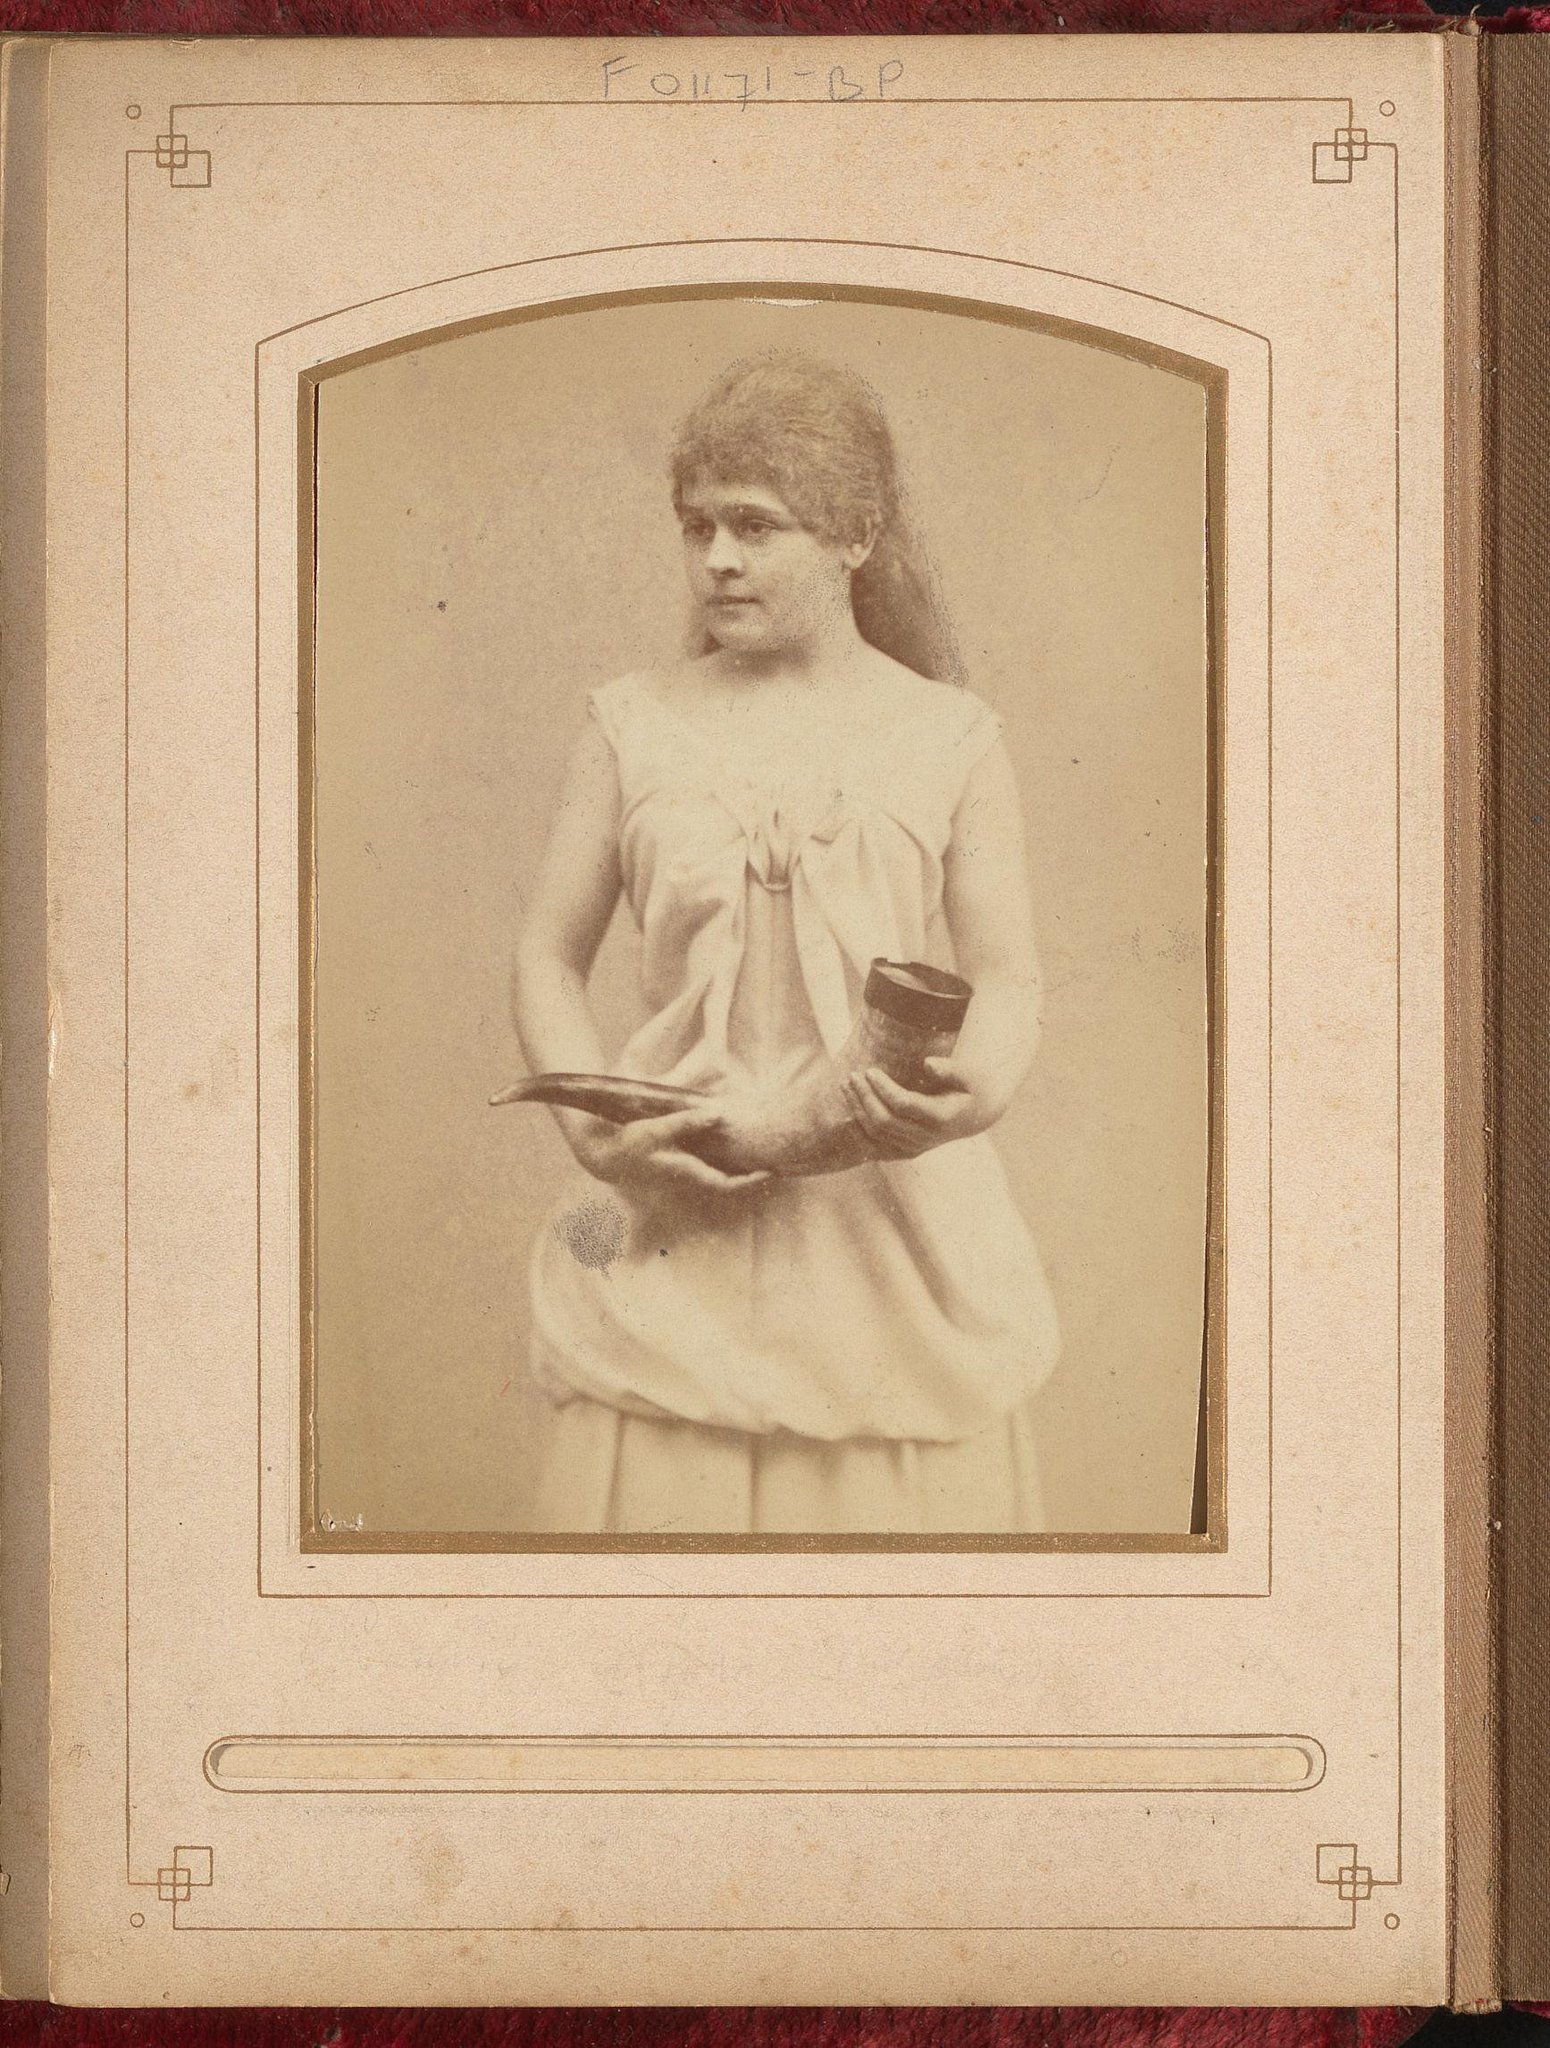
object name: cabinet photograph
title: Portret van een artiest met de hoorn des overvloeds in de handen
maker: johannes baer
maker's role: fotograaf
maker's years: 1840-1912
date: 1877-1891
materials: cardboard, photographic support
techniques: albumen print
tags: adult woman, portrait, self-portrait of artist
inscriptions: inscription: ‘POrtraits/ reproductien/ aquarelles/ J. Baer/ Schiedamschen Singel. 55/ Rotterdam’